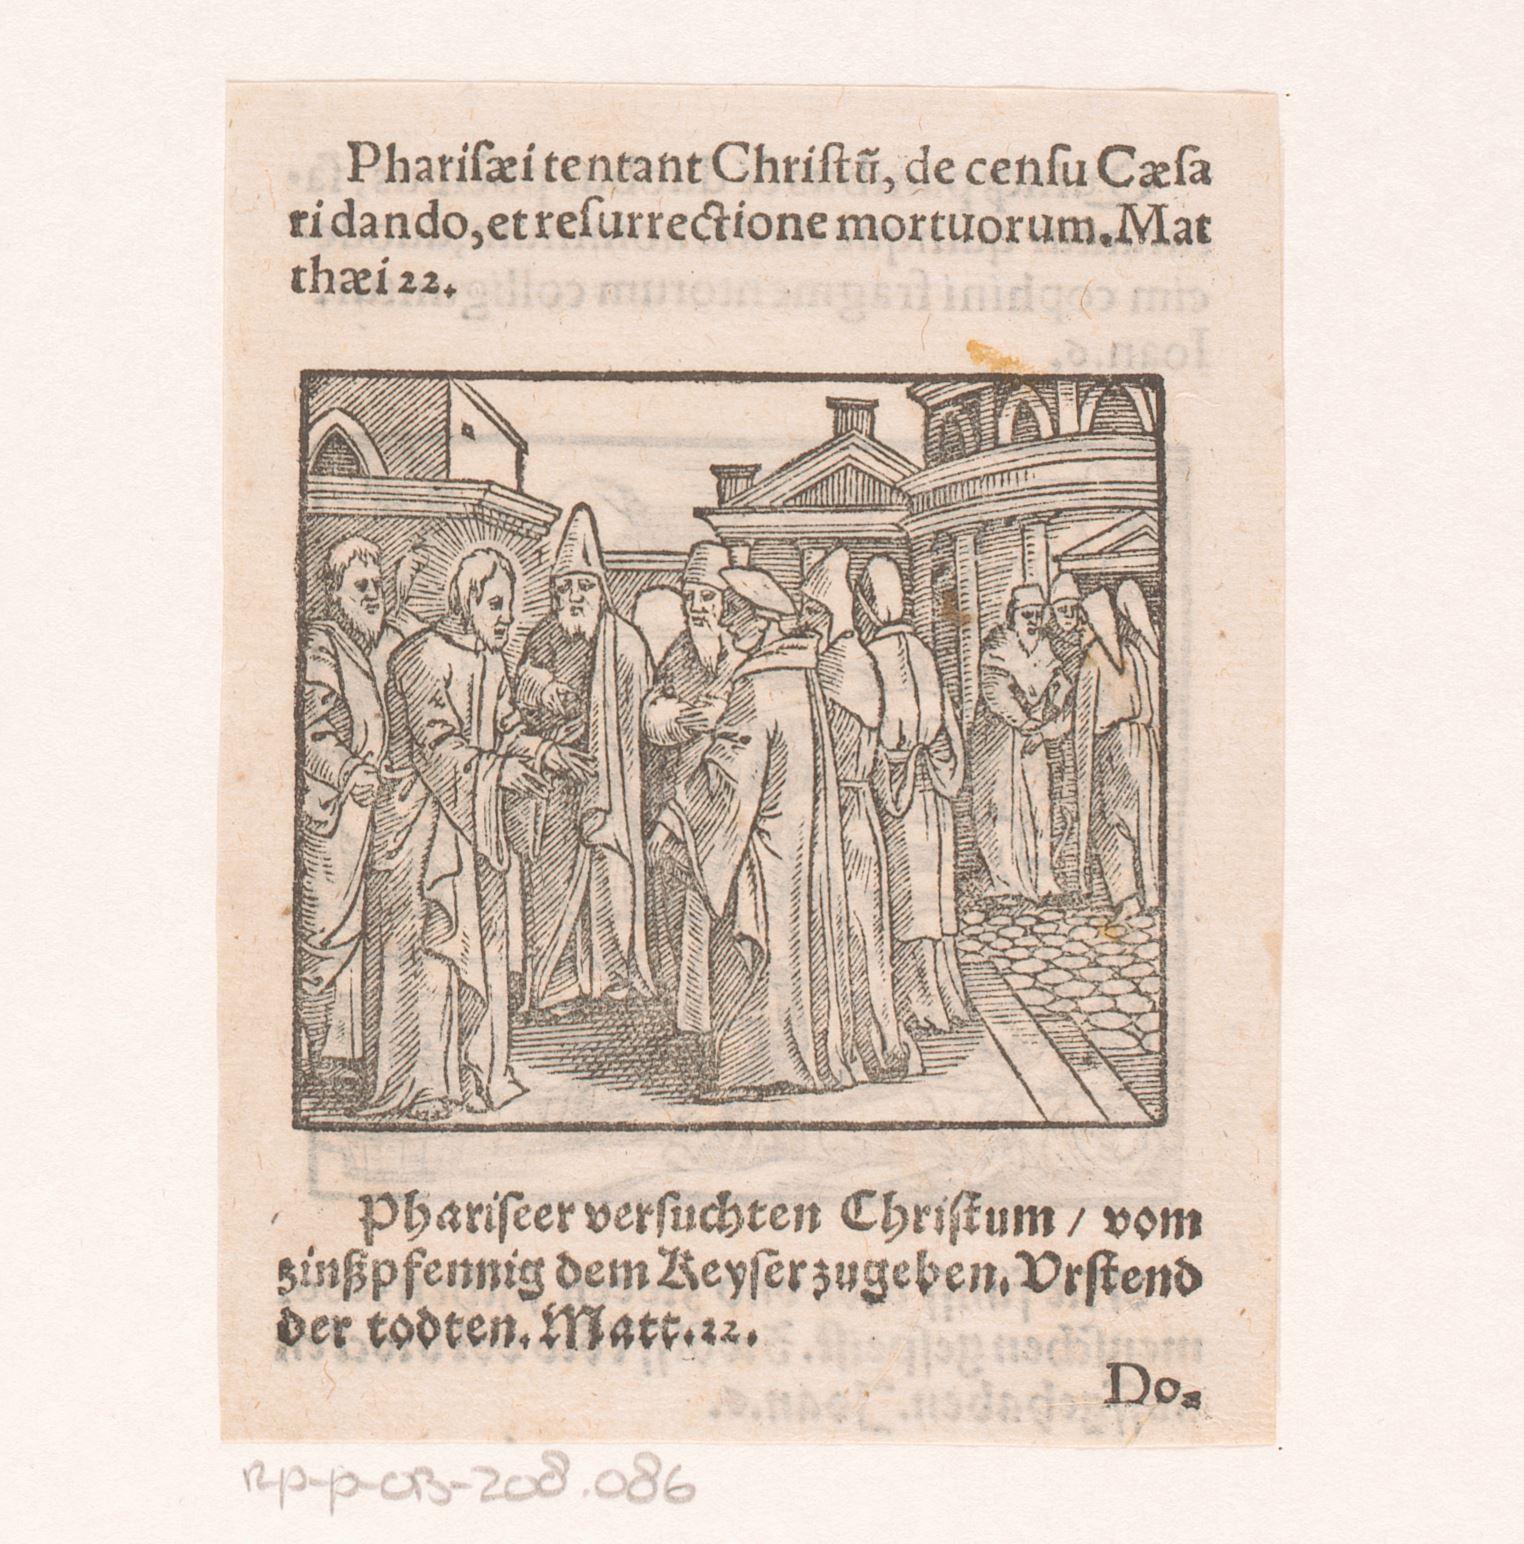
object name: print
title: Christus in debat met de farizeeën over de belasting aan de keizer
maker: Anonymous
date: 1600-1699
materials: paper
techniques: letterpress printing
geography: netherlands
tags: christ (in the temple) in debate with pharisees about the tribute to caesar (matthew 22:15-22; mark 12:13-17; luke 20:20-26)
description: Christus in debat met de farizeeën. Een van de farizeeën toont hem een munt en vraagt aan Christus of het toegestaan is belasting aan de keizer te betalen.